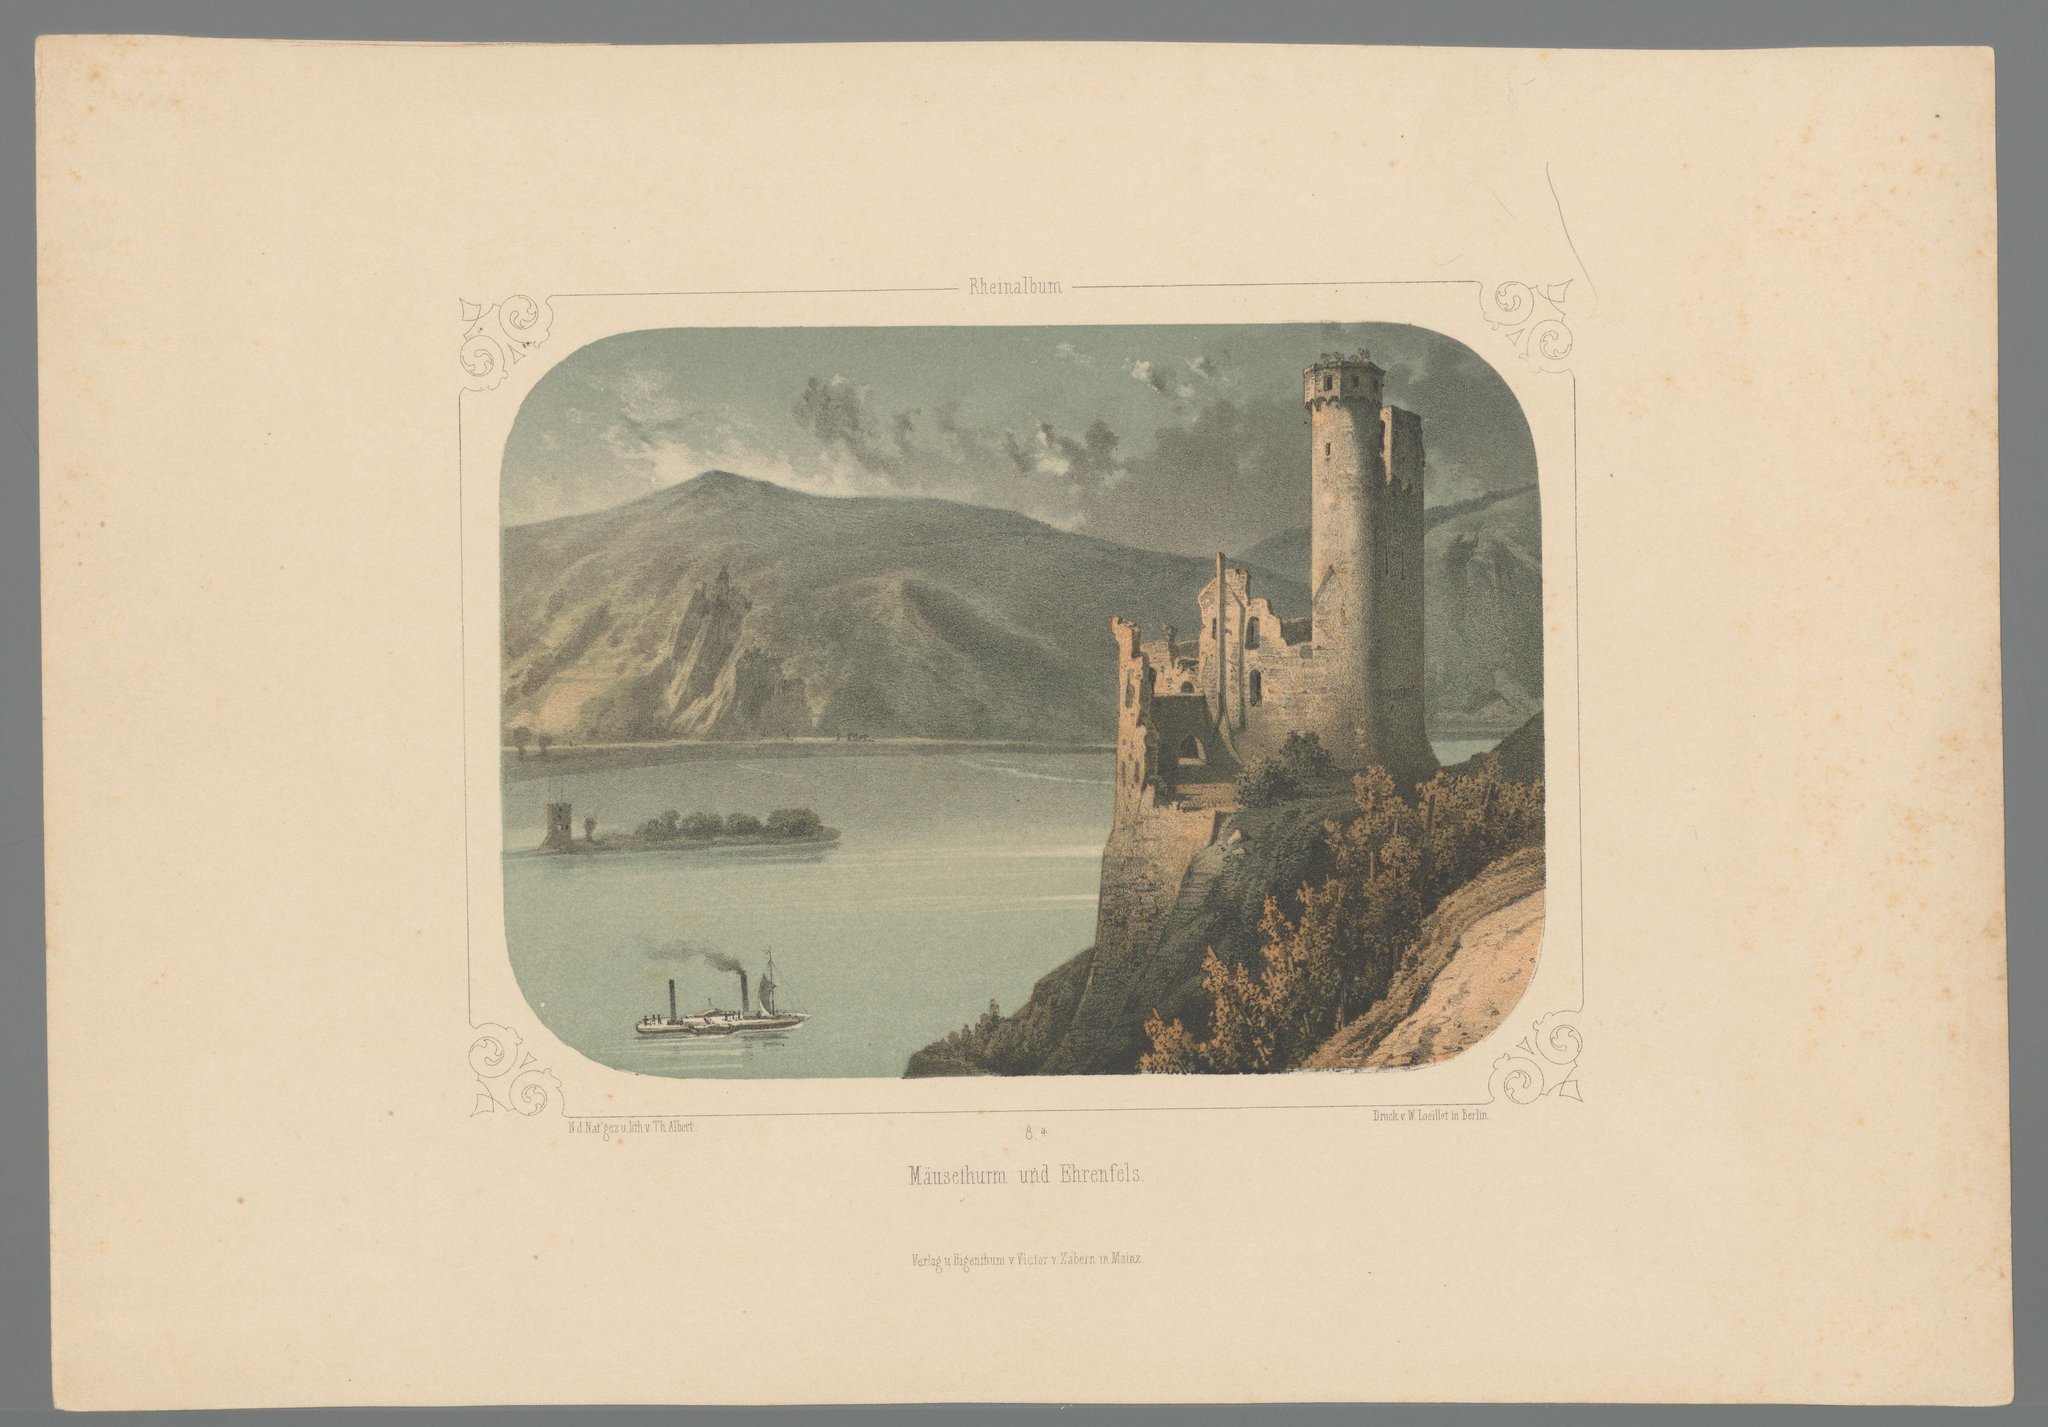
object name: print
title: Gezicht op de Muizentoren bij Bingen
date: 1858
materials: paper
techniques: lithograph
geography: berlin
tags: river, landscape with tower or castle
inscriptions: collector's mark: Lugt 2228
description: Prent maakt deel uit van een serie van 36 prenten, waarbij het eveneens mogelijk was deze te laten samenbinden tot een album.